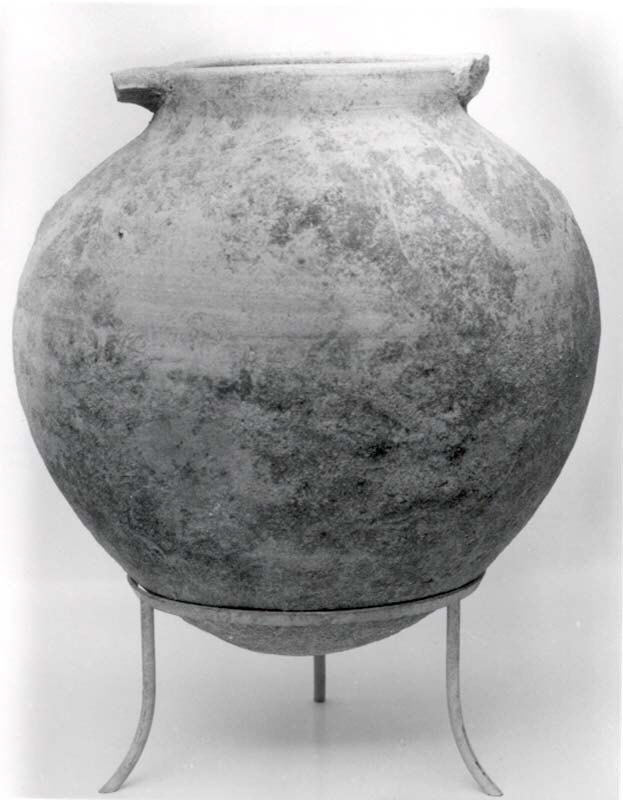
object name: jar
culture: sasanian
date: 201-700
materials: ceramic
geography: mesopotamia